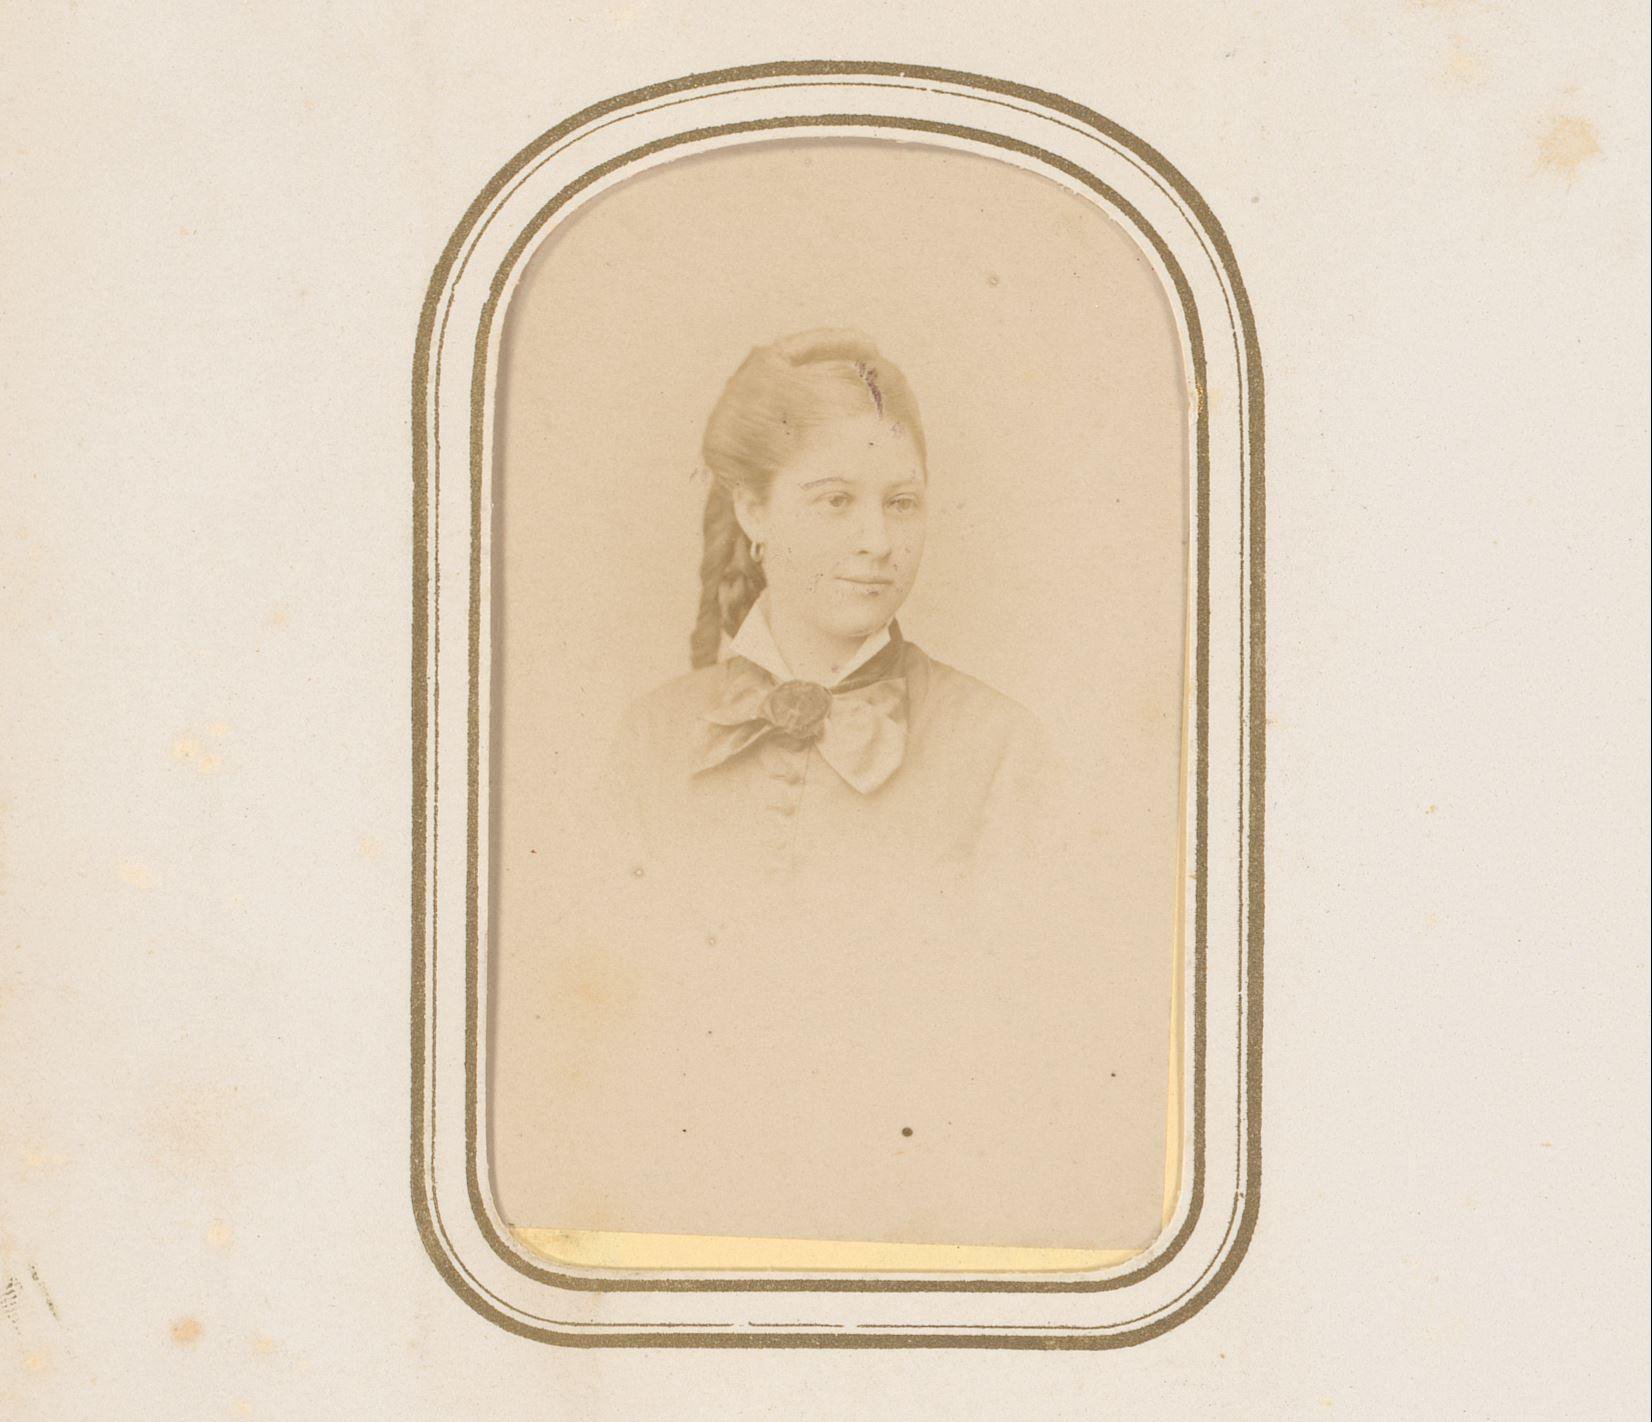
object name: photograph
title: Portret van een jonge vrouw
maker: emile tourtin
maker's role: fotograaf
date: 1850-1890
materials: cardboard, photographic support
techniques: albumen print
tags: adolescent, young woman, maiden, historical persons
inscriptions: inscription: ‘Peinture & Photographie d'Art/ Emile Tourtin/8, Bould des Italiens/ Mon Robert Houdin/ Paris/ (...)’